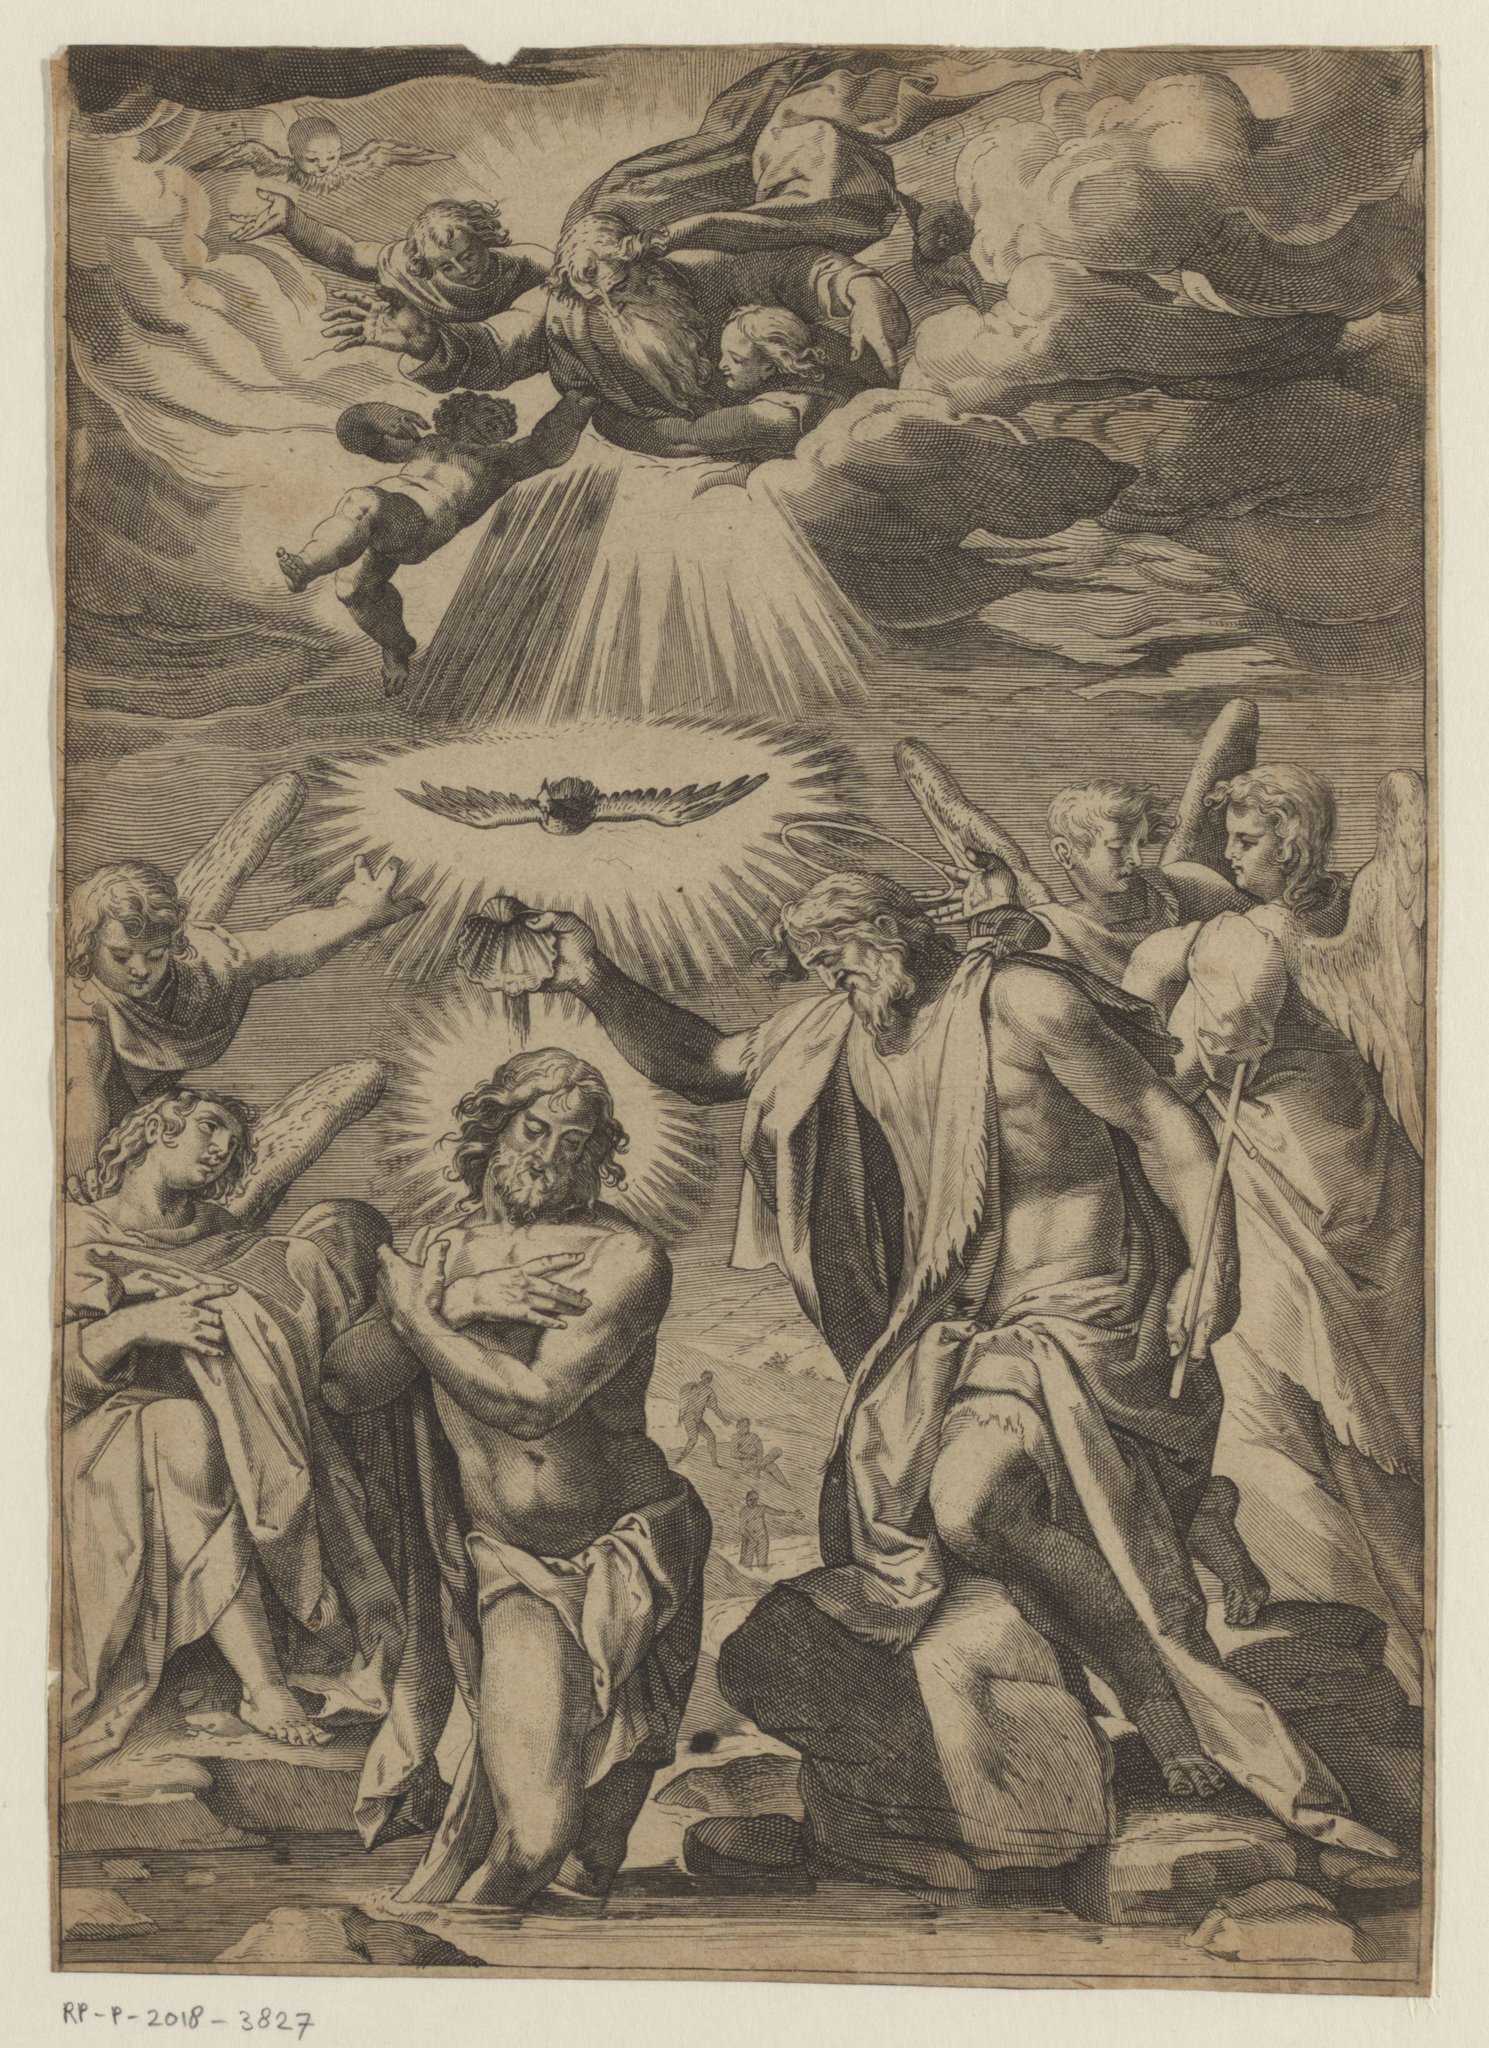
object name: print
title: Doop van Christus in de Jordaan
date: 1575-1650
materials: paper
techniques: engraving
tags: baptism of christ in the river jordan: john the baptist pouring out water on christ's head: the holy ghost descends, angels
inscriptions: collector's mark: Lugt 2228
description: Christus staat met zijn voeten in het water van de rivier, de handen gevouwen voor de borst. Johannes de Doper giet water over zijn hoofd. Boven hem de H. Geest in de gedaante van een duif en God als oude man, met engelen in een lichtgevende wolk. Vier engelen kijken toe.